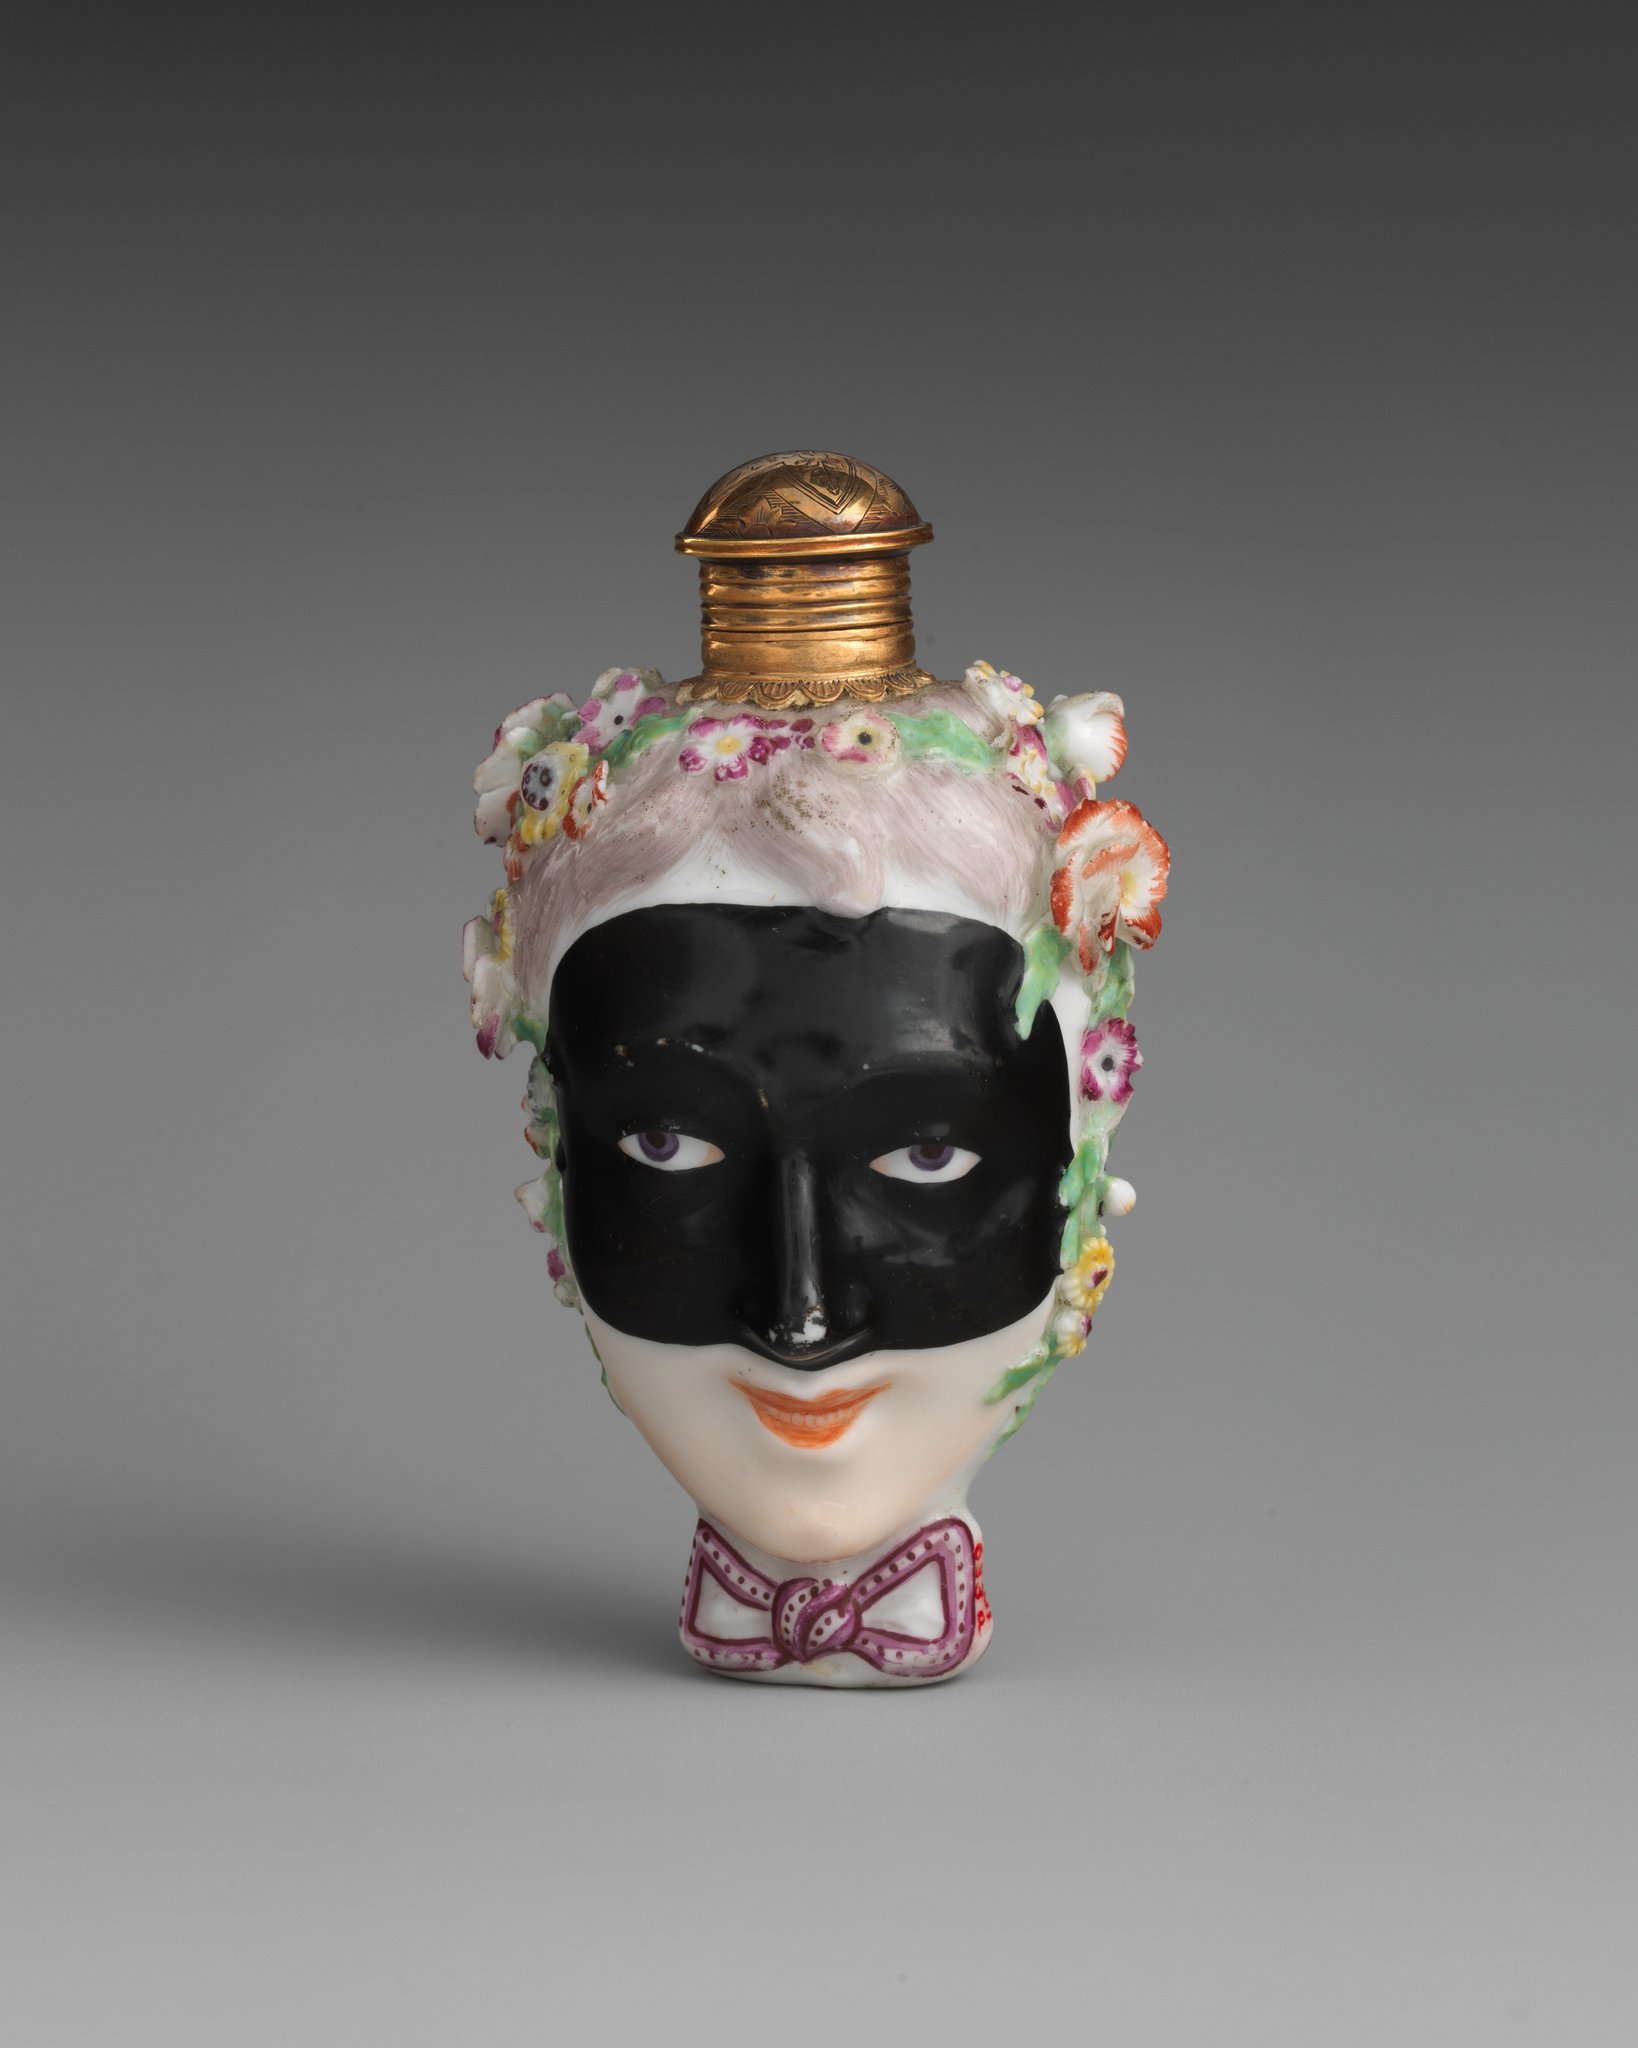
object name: toy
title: Janus-headed bottle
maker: chelsea porcelain manufactory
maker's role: factory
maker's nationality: british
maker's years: 1744-1784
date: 1760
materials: soft paste porcelain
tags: masks,heads,flowers